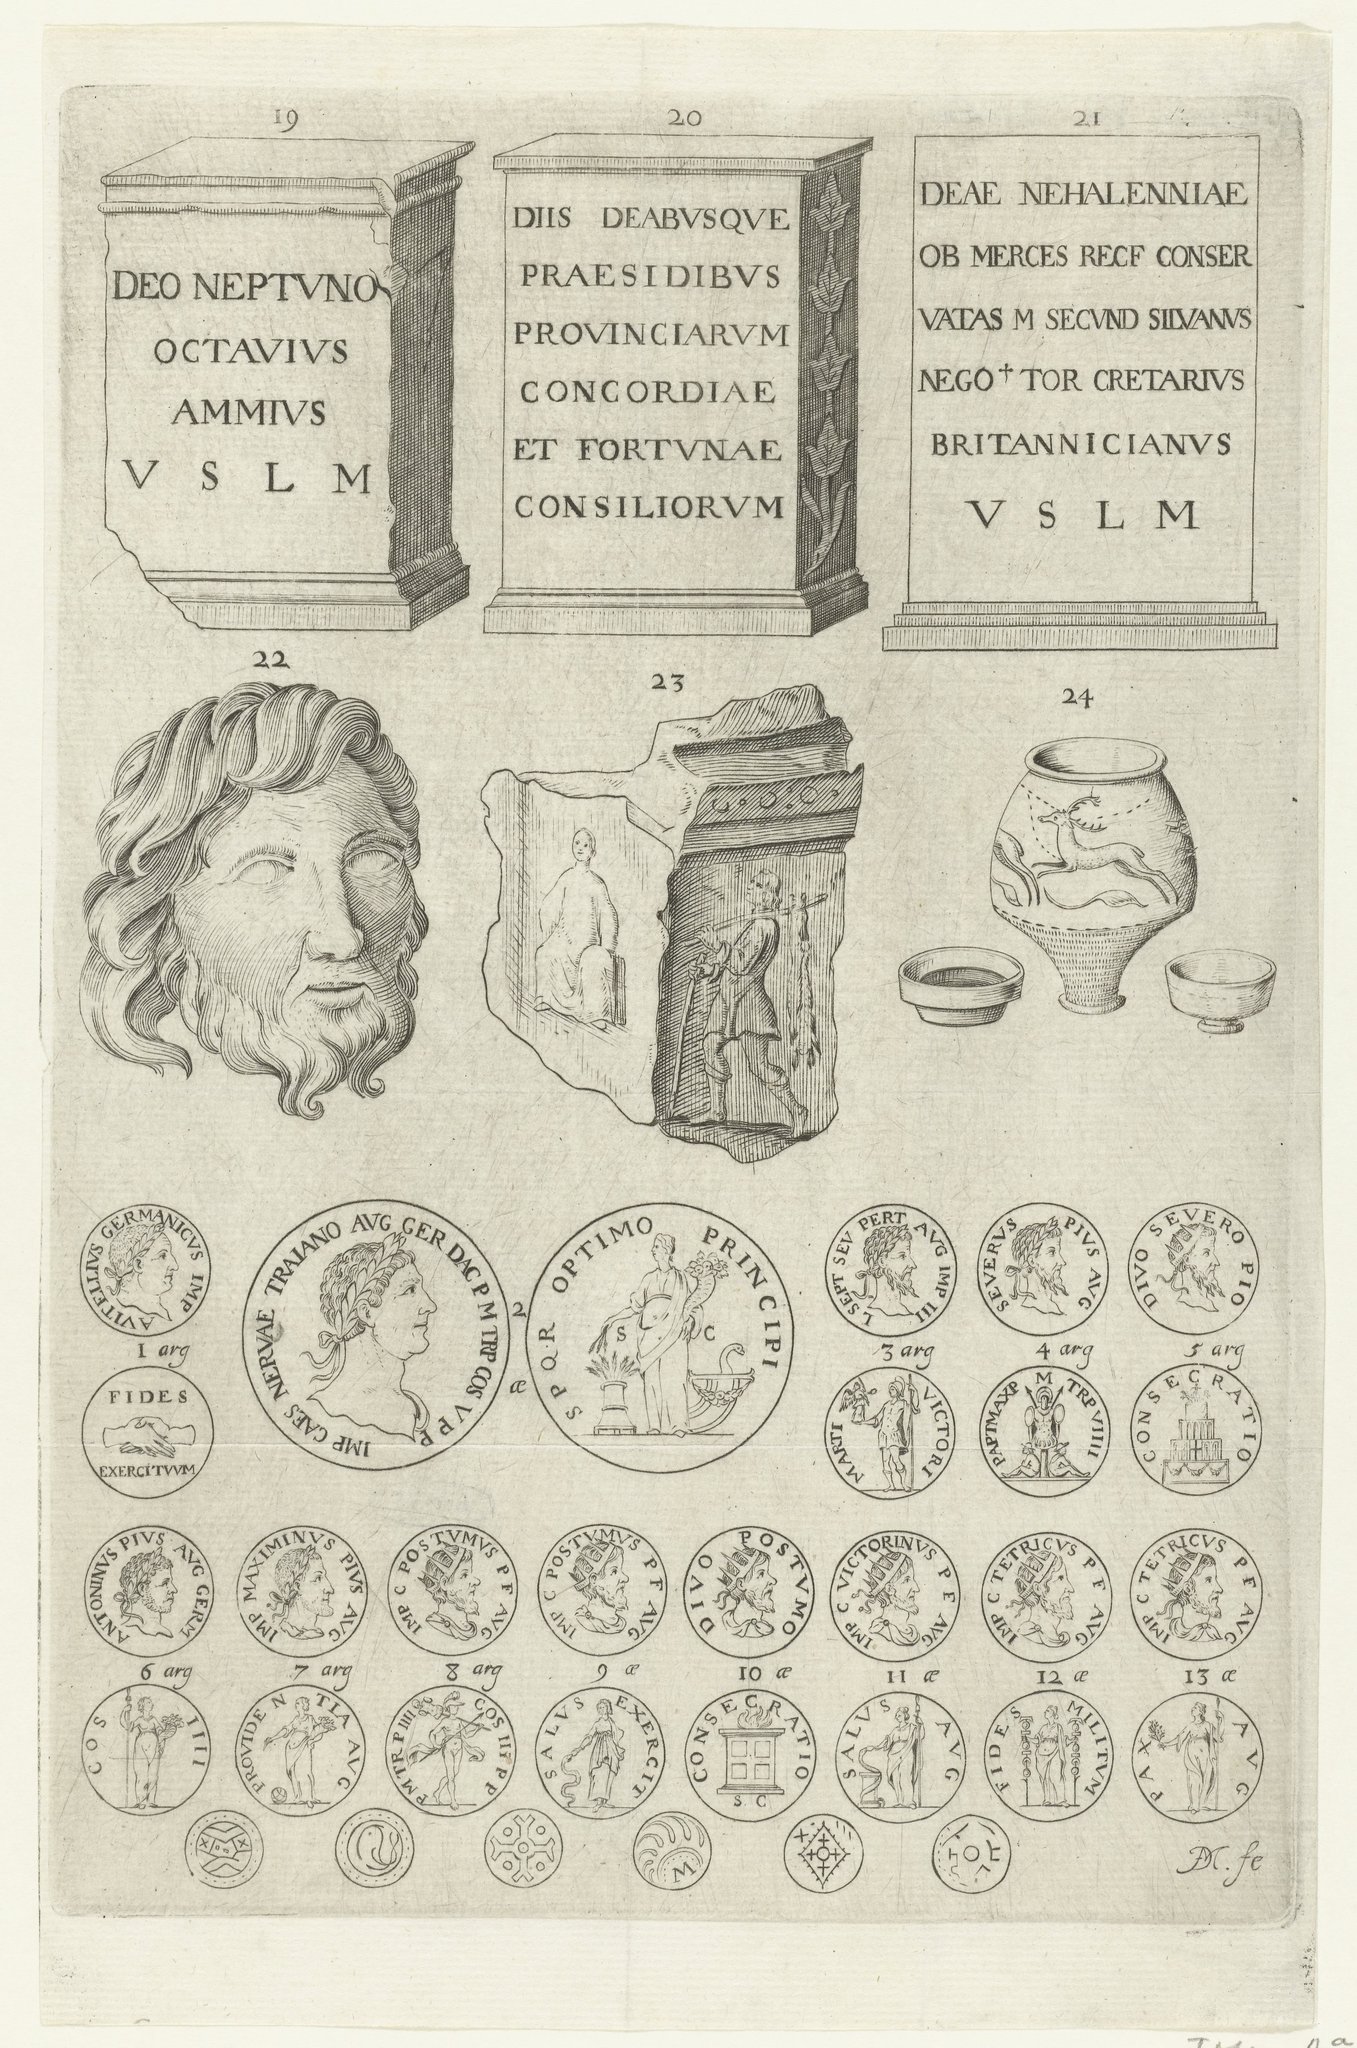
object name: historical object representation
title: Romeinse altaarstenen en munten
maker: jan de mel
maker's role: print maker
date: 1648-1650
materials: paper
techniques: engraving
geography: netherlands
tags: coin, other foreign deities included in the classical pantheon (with name)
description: Blad met overzicht van Romeinse altaarstenen en munten, genummerd 19-24. Afkomstig uit: Olivier de Wree, Historiae comitum Flandriae libri prodromiduo, Lucas van den Kerchove, Brugge 1650. Tweede staat waarin de pagina en nummer rechtsboven zijn verwijderd.